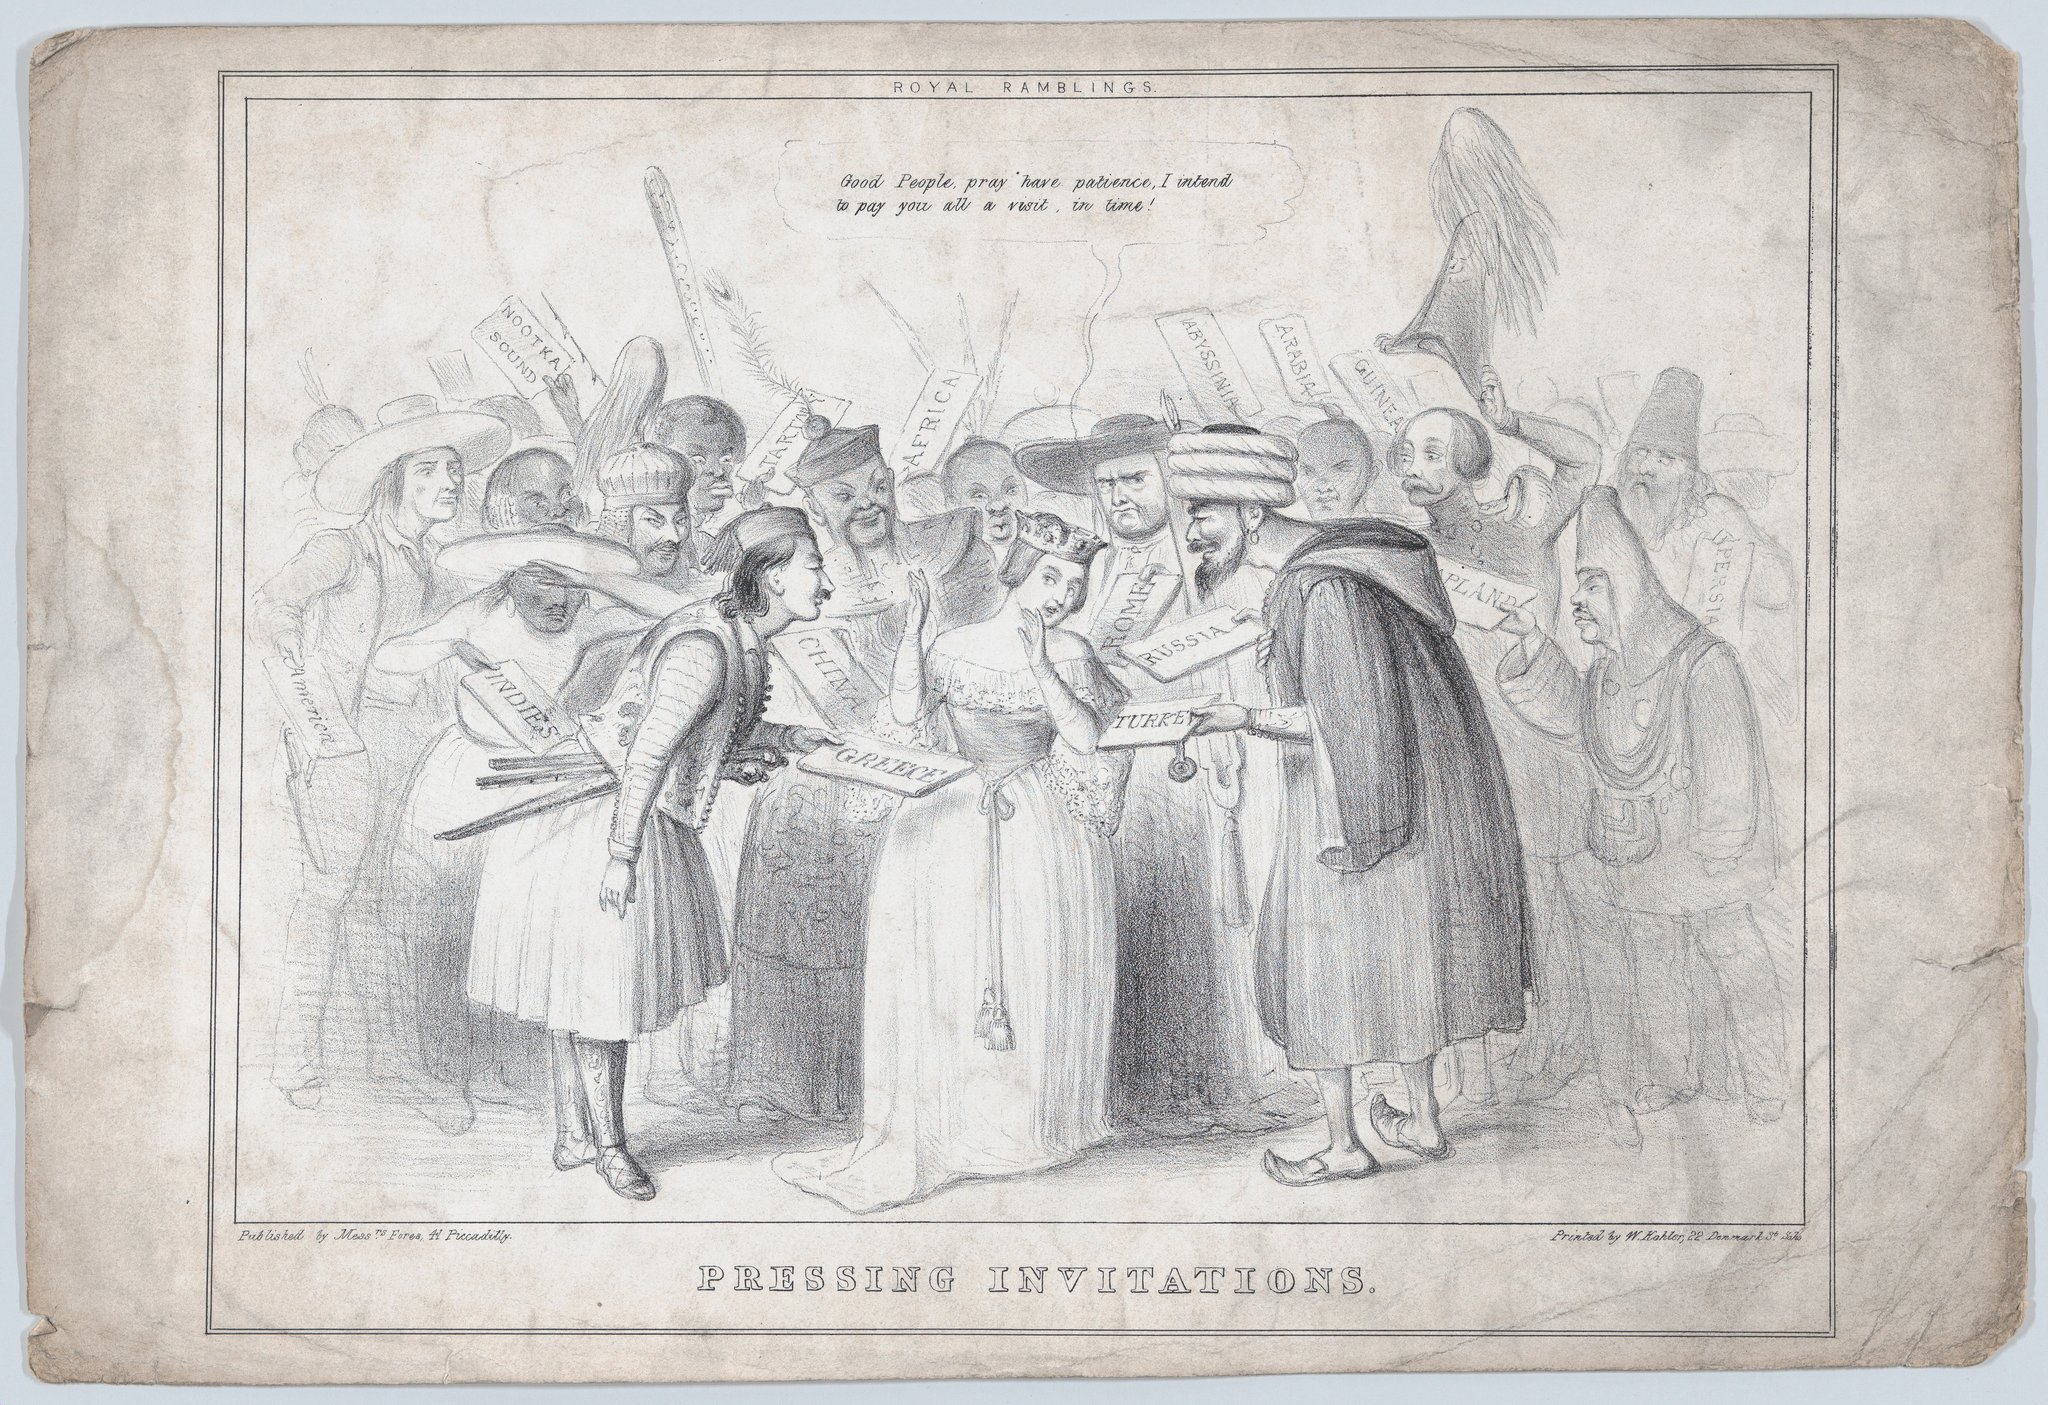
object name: print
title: Pressing Invitations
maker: mssrs. fores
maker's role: publisher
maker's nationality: british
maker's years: 1761-1999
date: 1839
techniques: lithograph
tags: men,women